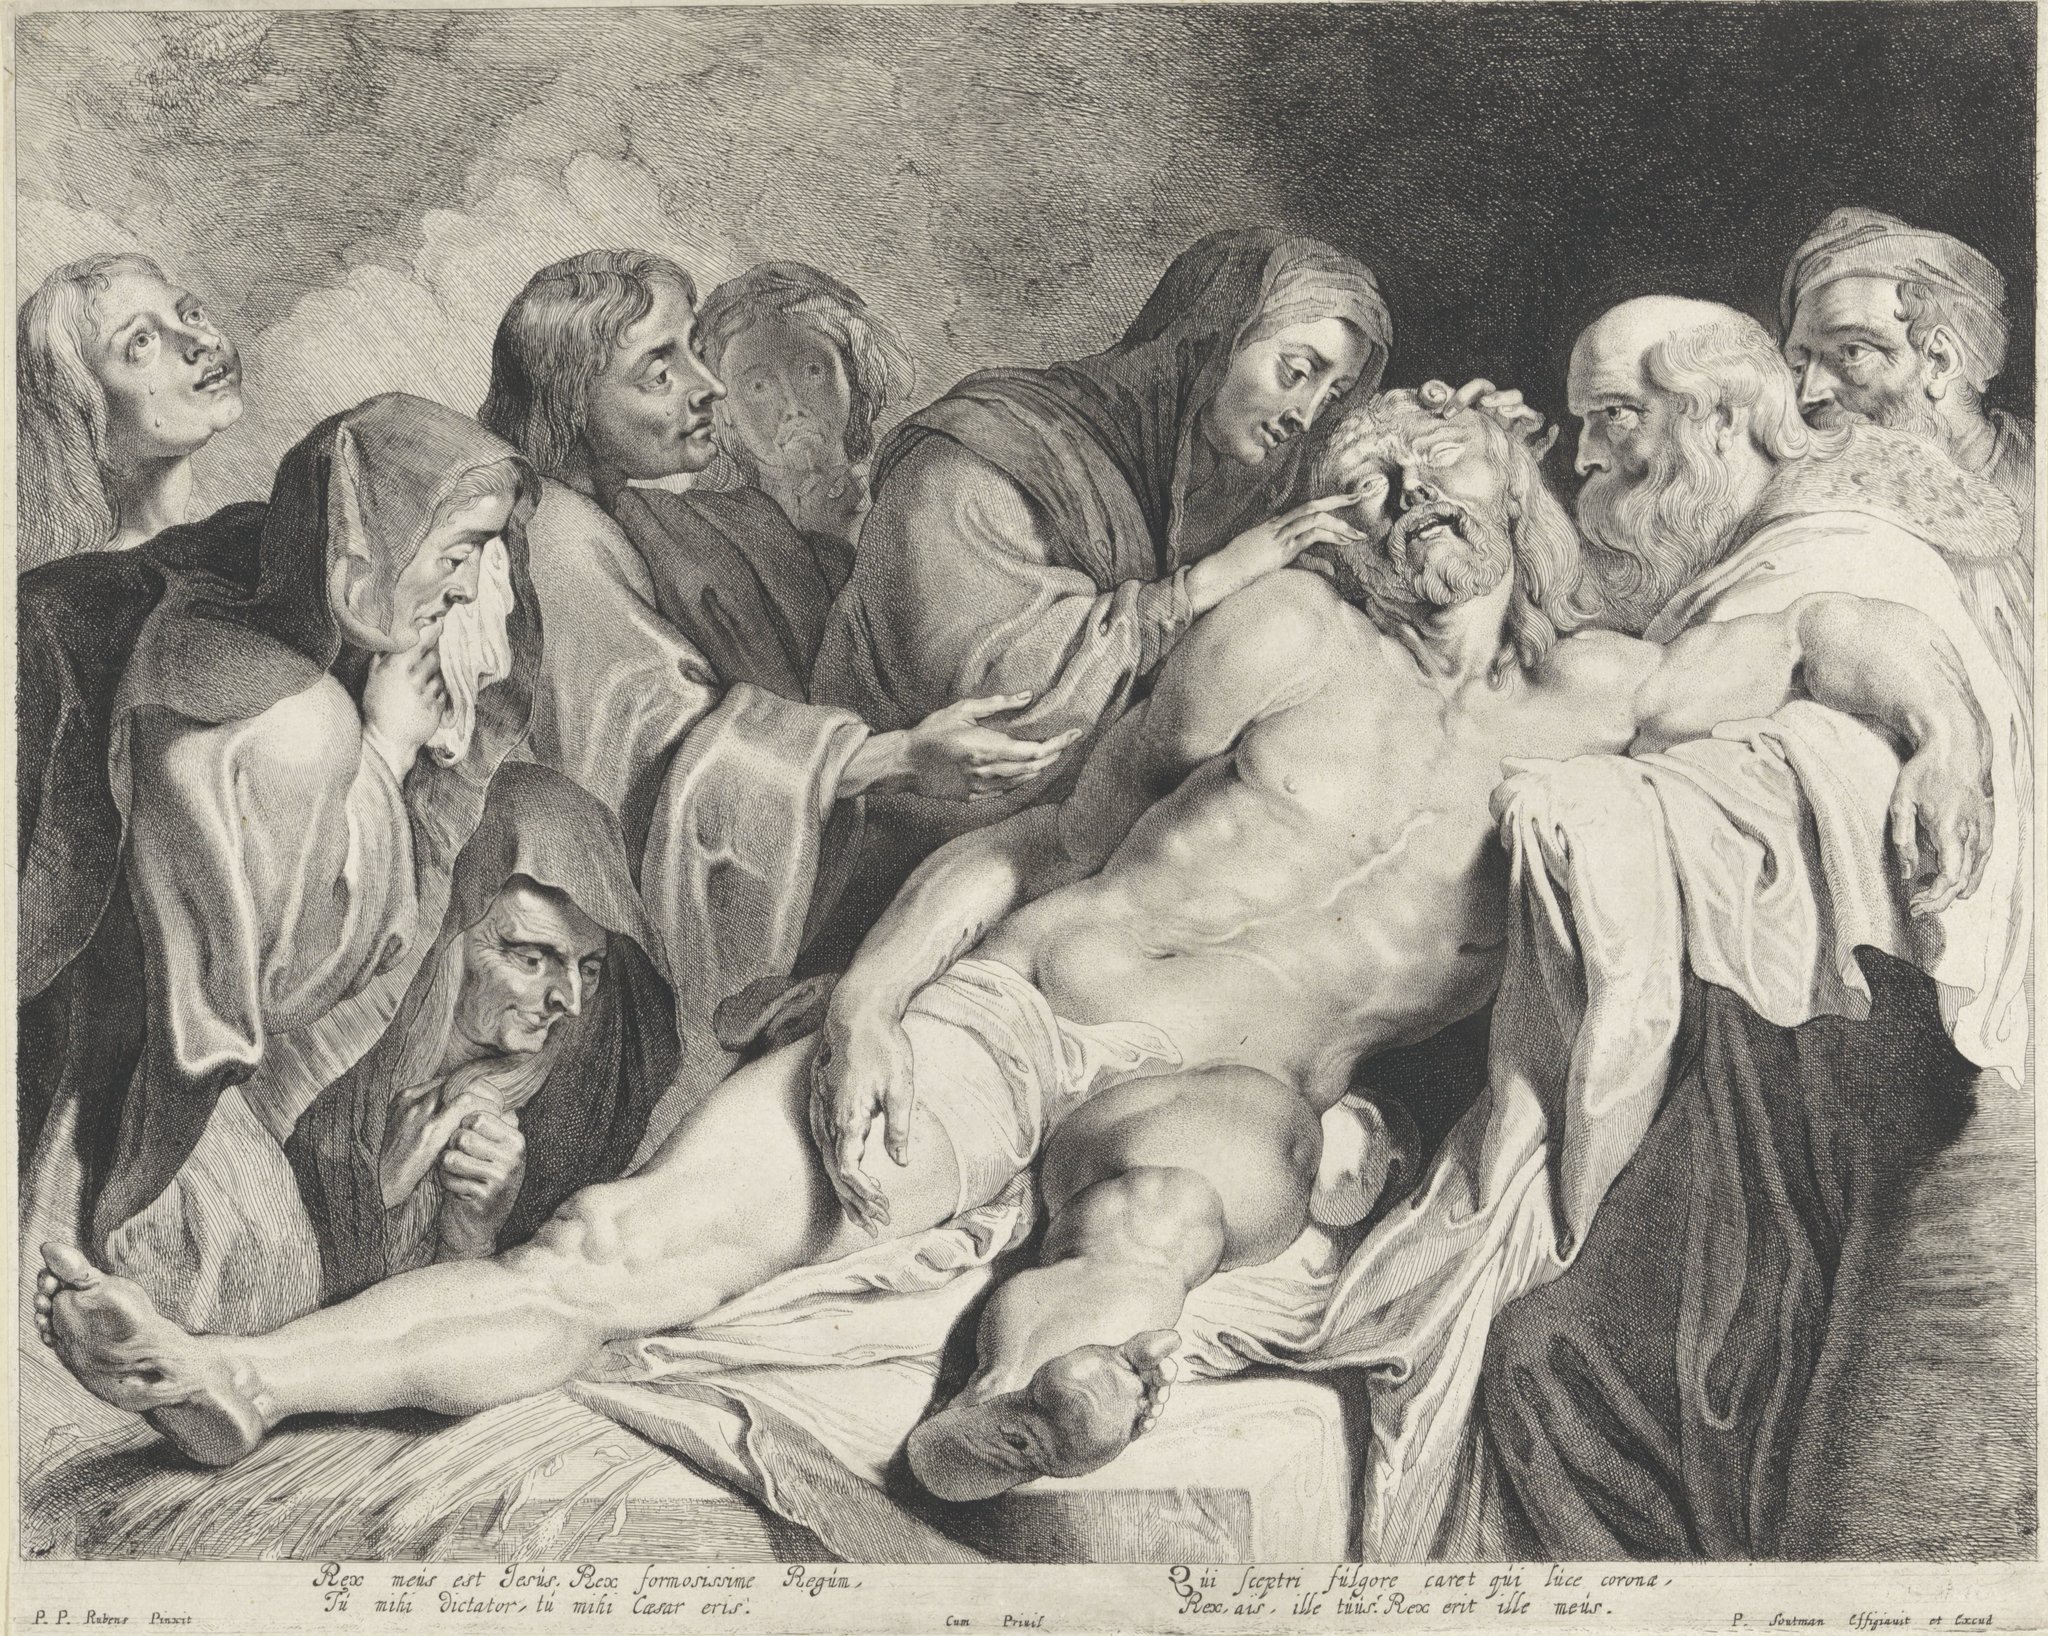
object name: print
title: Bewening van Christus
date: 1616-1657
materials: paper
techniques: engraving, etching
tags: lamentation over the dead christ by his relatives and friends (christ usually without crown of thorns)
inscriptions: collector's mark: Lugt 240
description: Bewening van Christus. Onder de voorstelling een epigram in het Latijn van de hand van de Poolse dichter Maciej Kazimierz Sarbiewski.